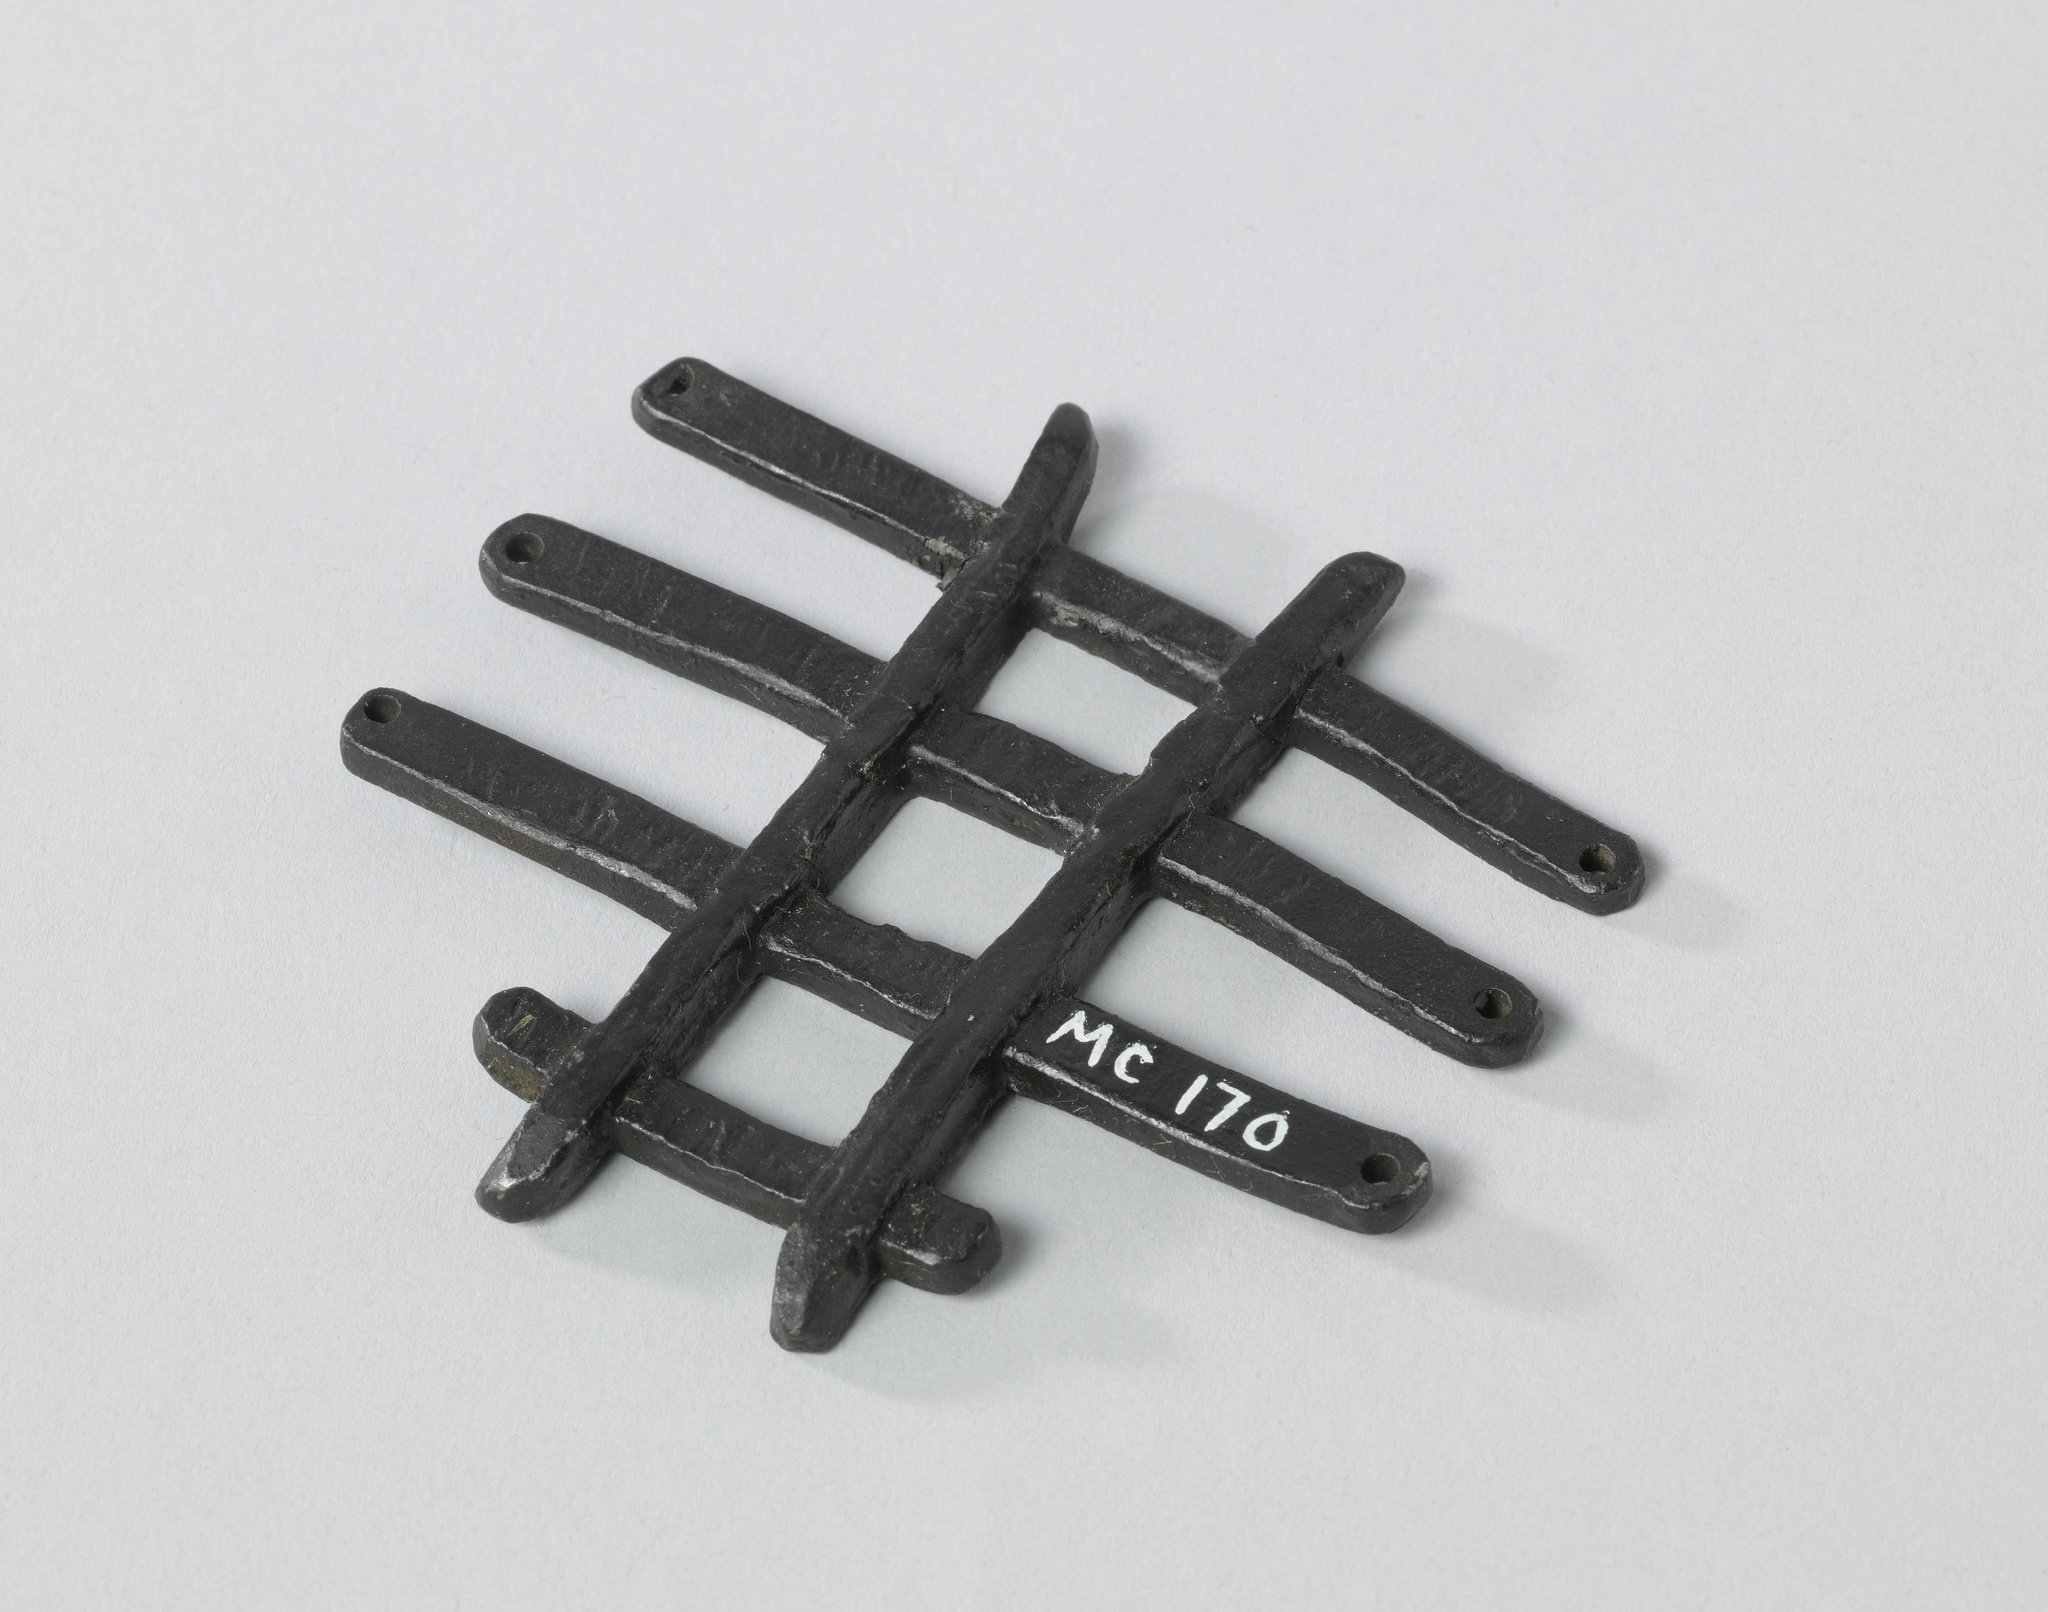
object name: scale model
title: Model of Topgallant Crosstrees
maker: Anonymous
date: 1750-1800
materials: lead, paint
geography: netherlands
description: Bramzalingen bestaande uit langszalingen, drie dwarszalingen en een dwarsbalk, van lood gegoten en zwart geschilderd. Waarschijnlijk een fragment van een groot scheepsmodel. Mogelijk een model.